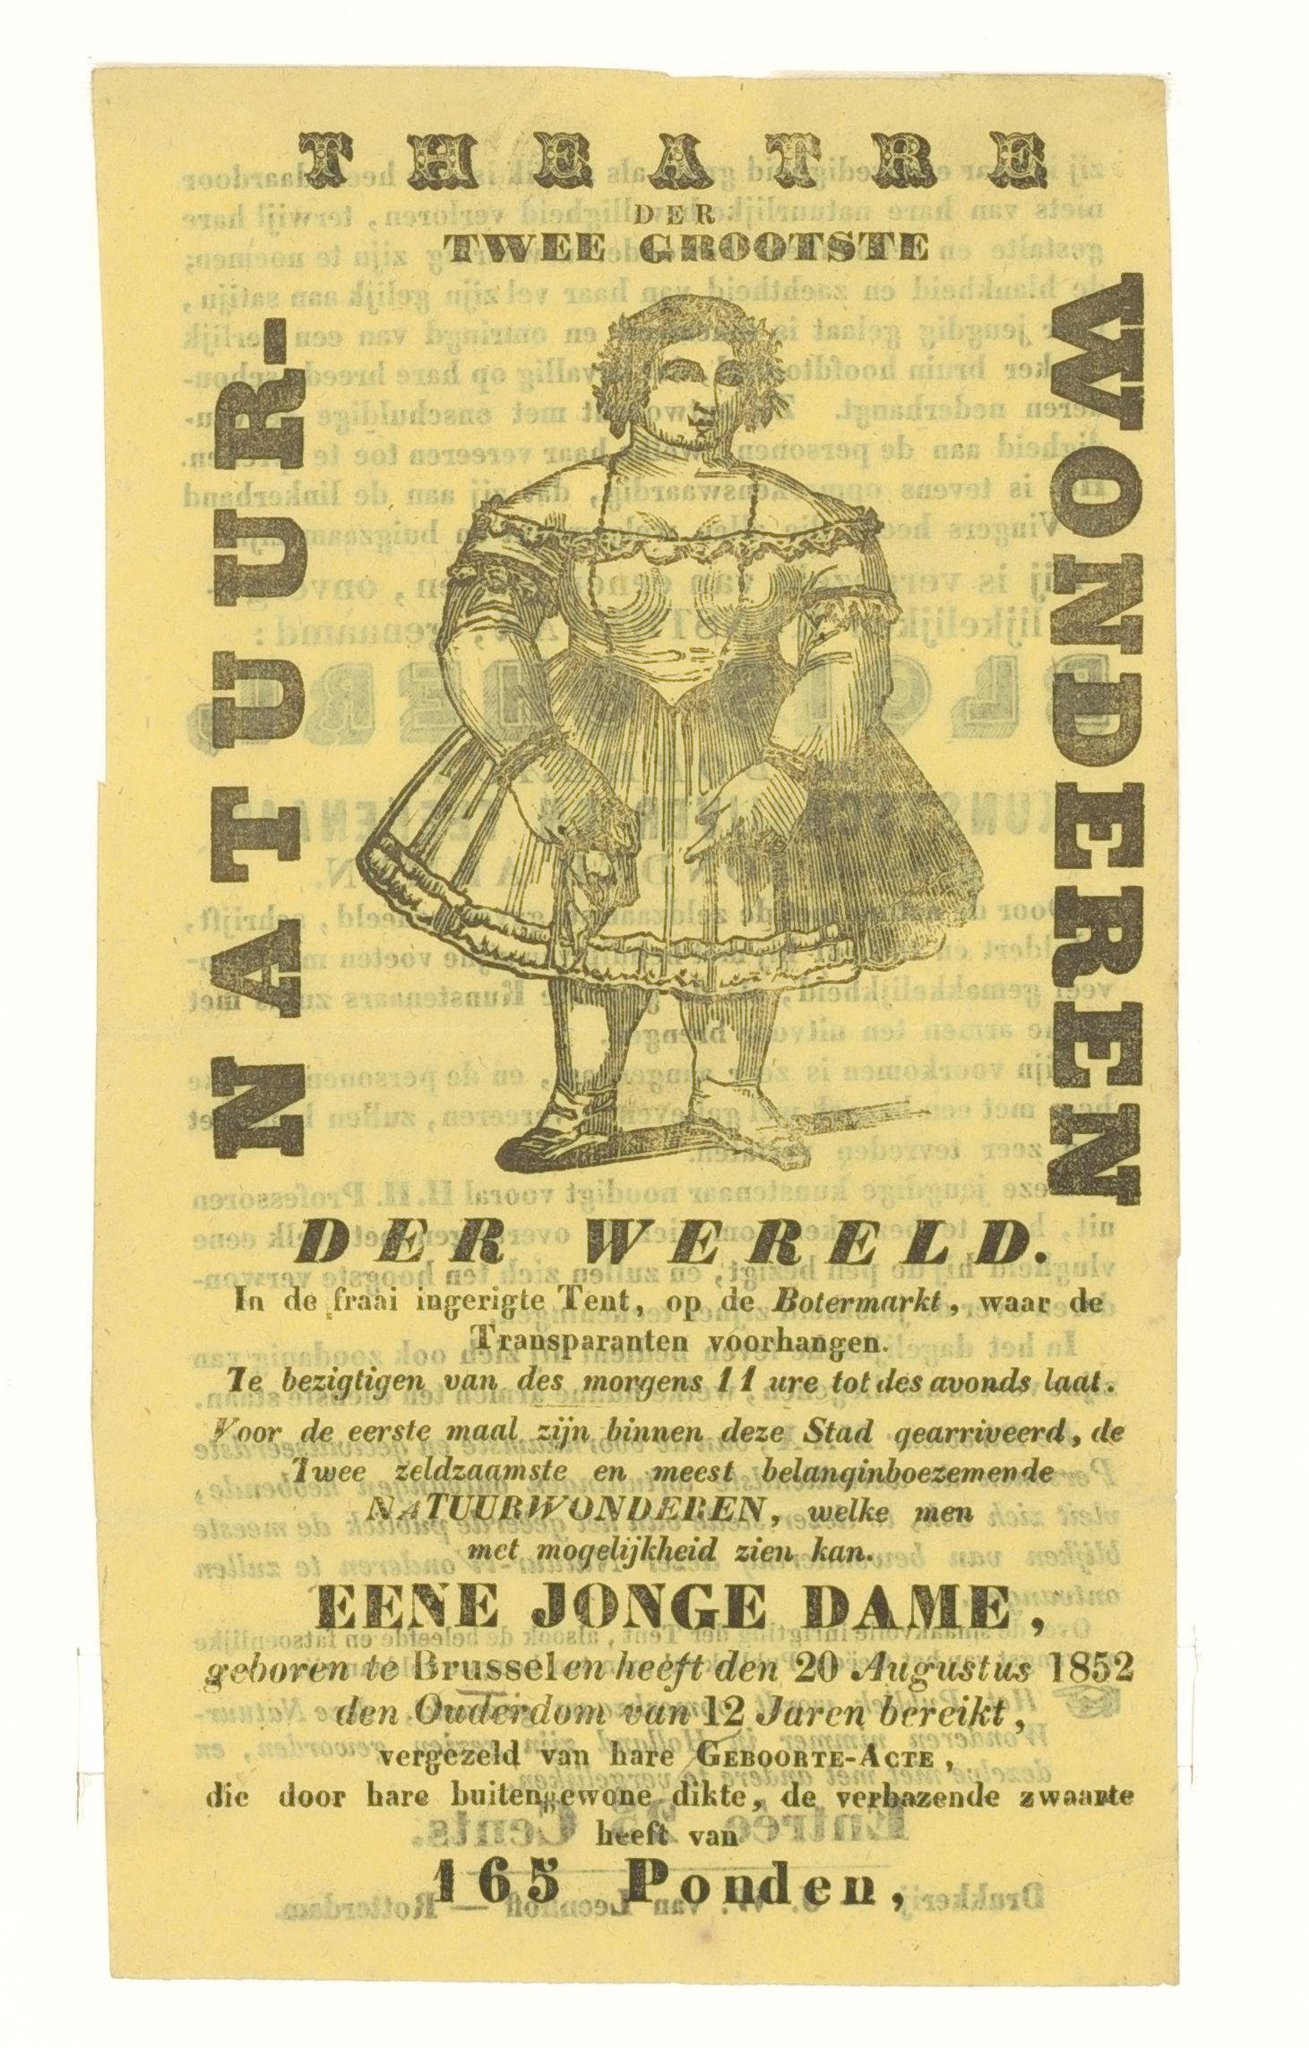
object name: print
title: Meisje met zes vingers en een gewicht van 165 pond tentoongesteld op de kermis in 1853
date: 1850-1860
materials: paper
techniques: letterpress printing, engraving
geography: rotterdam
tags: human monstrosities ~ freak show, fingers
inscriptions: stamp, stamp: Lugt 1641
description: Twaalf-jarig meisje met zes vingers en een gewicht van 165 pond op een podium. Zij werd tentoongesteld op de Botermarkt samen met Blois Cheri, een kunstenaar zonder armen uit Bordeaux. Onderwerpsrubrieken binnen de Atlas Zeden en Gewoonten: Zeden en Gewoonten in Engeren Zin. Volksleven. Volksfeesten. Kermistypen, wondermenschen en dergelijken.